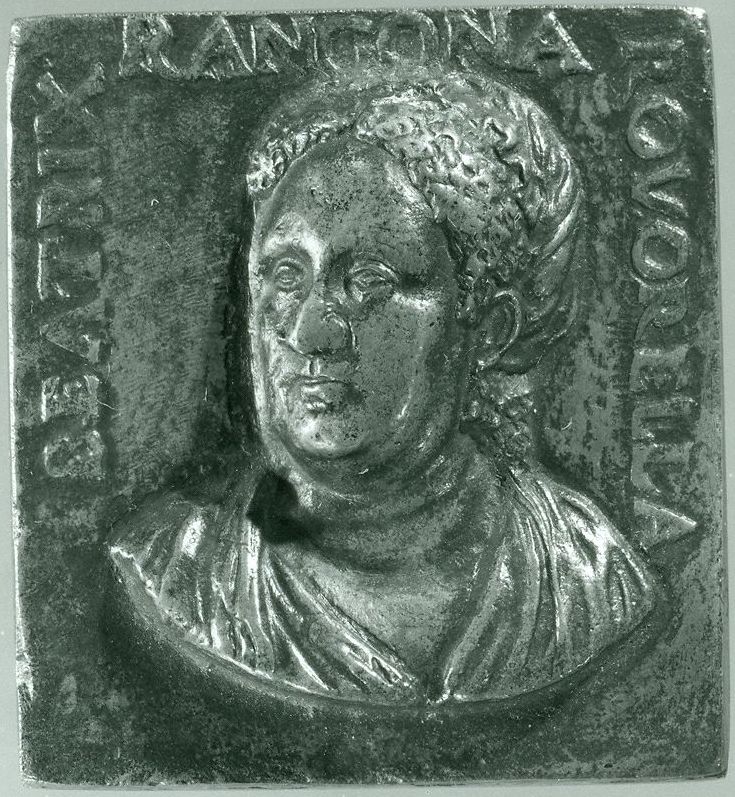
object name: medal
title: Medal: Bust of Beatric Roverella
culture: italian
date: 1550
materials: bronze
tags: portraits,women